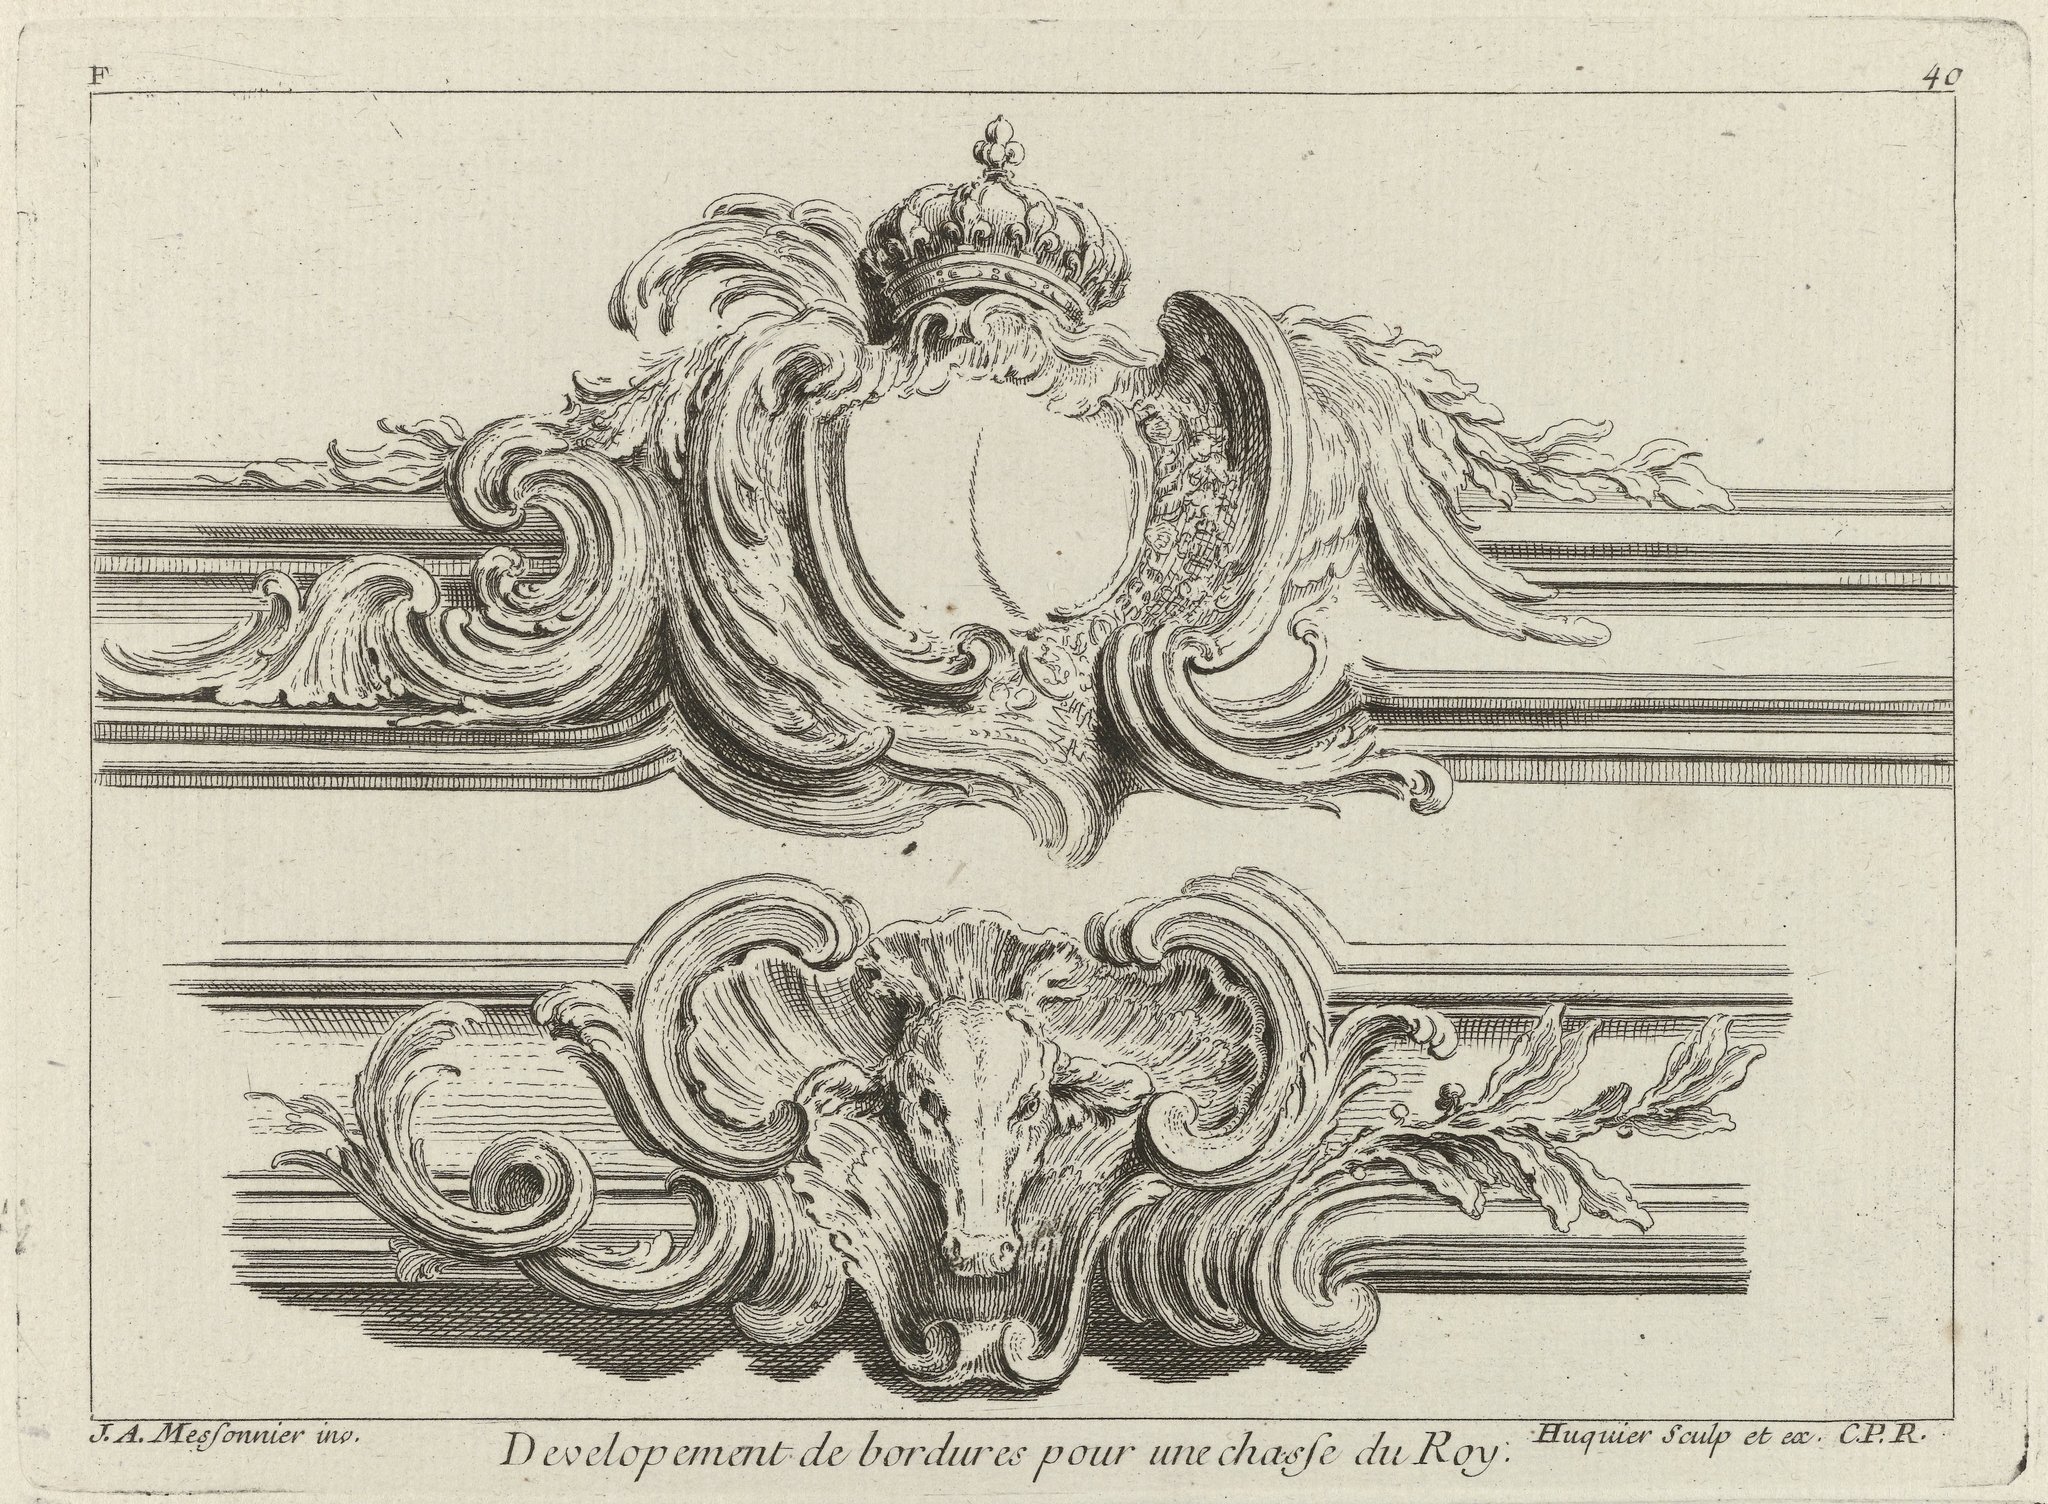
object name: ornament print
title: Wapen van de Franse koning in een fragment van de rand om een portret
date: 1738-1749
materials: paper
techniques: etching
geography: paris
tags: coat of arms (symbol of sovereignty), rocaille ornament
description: Vierde prent uit een serie van zeven met fragmenten van ornamentranden.